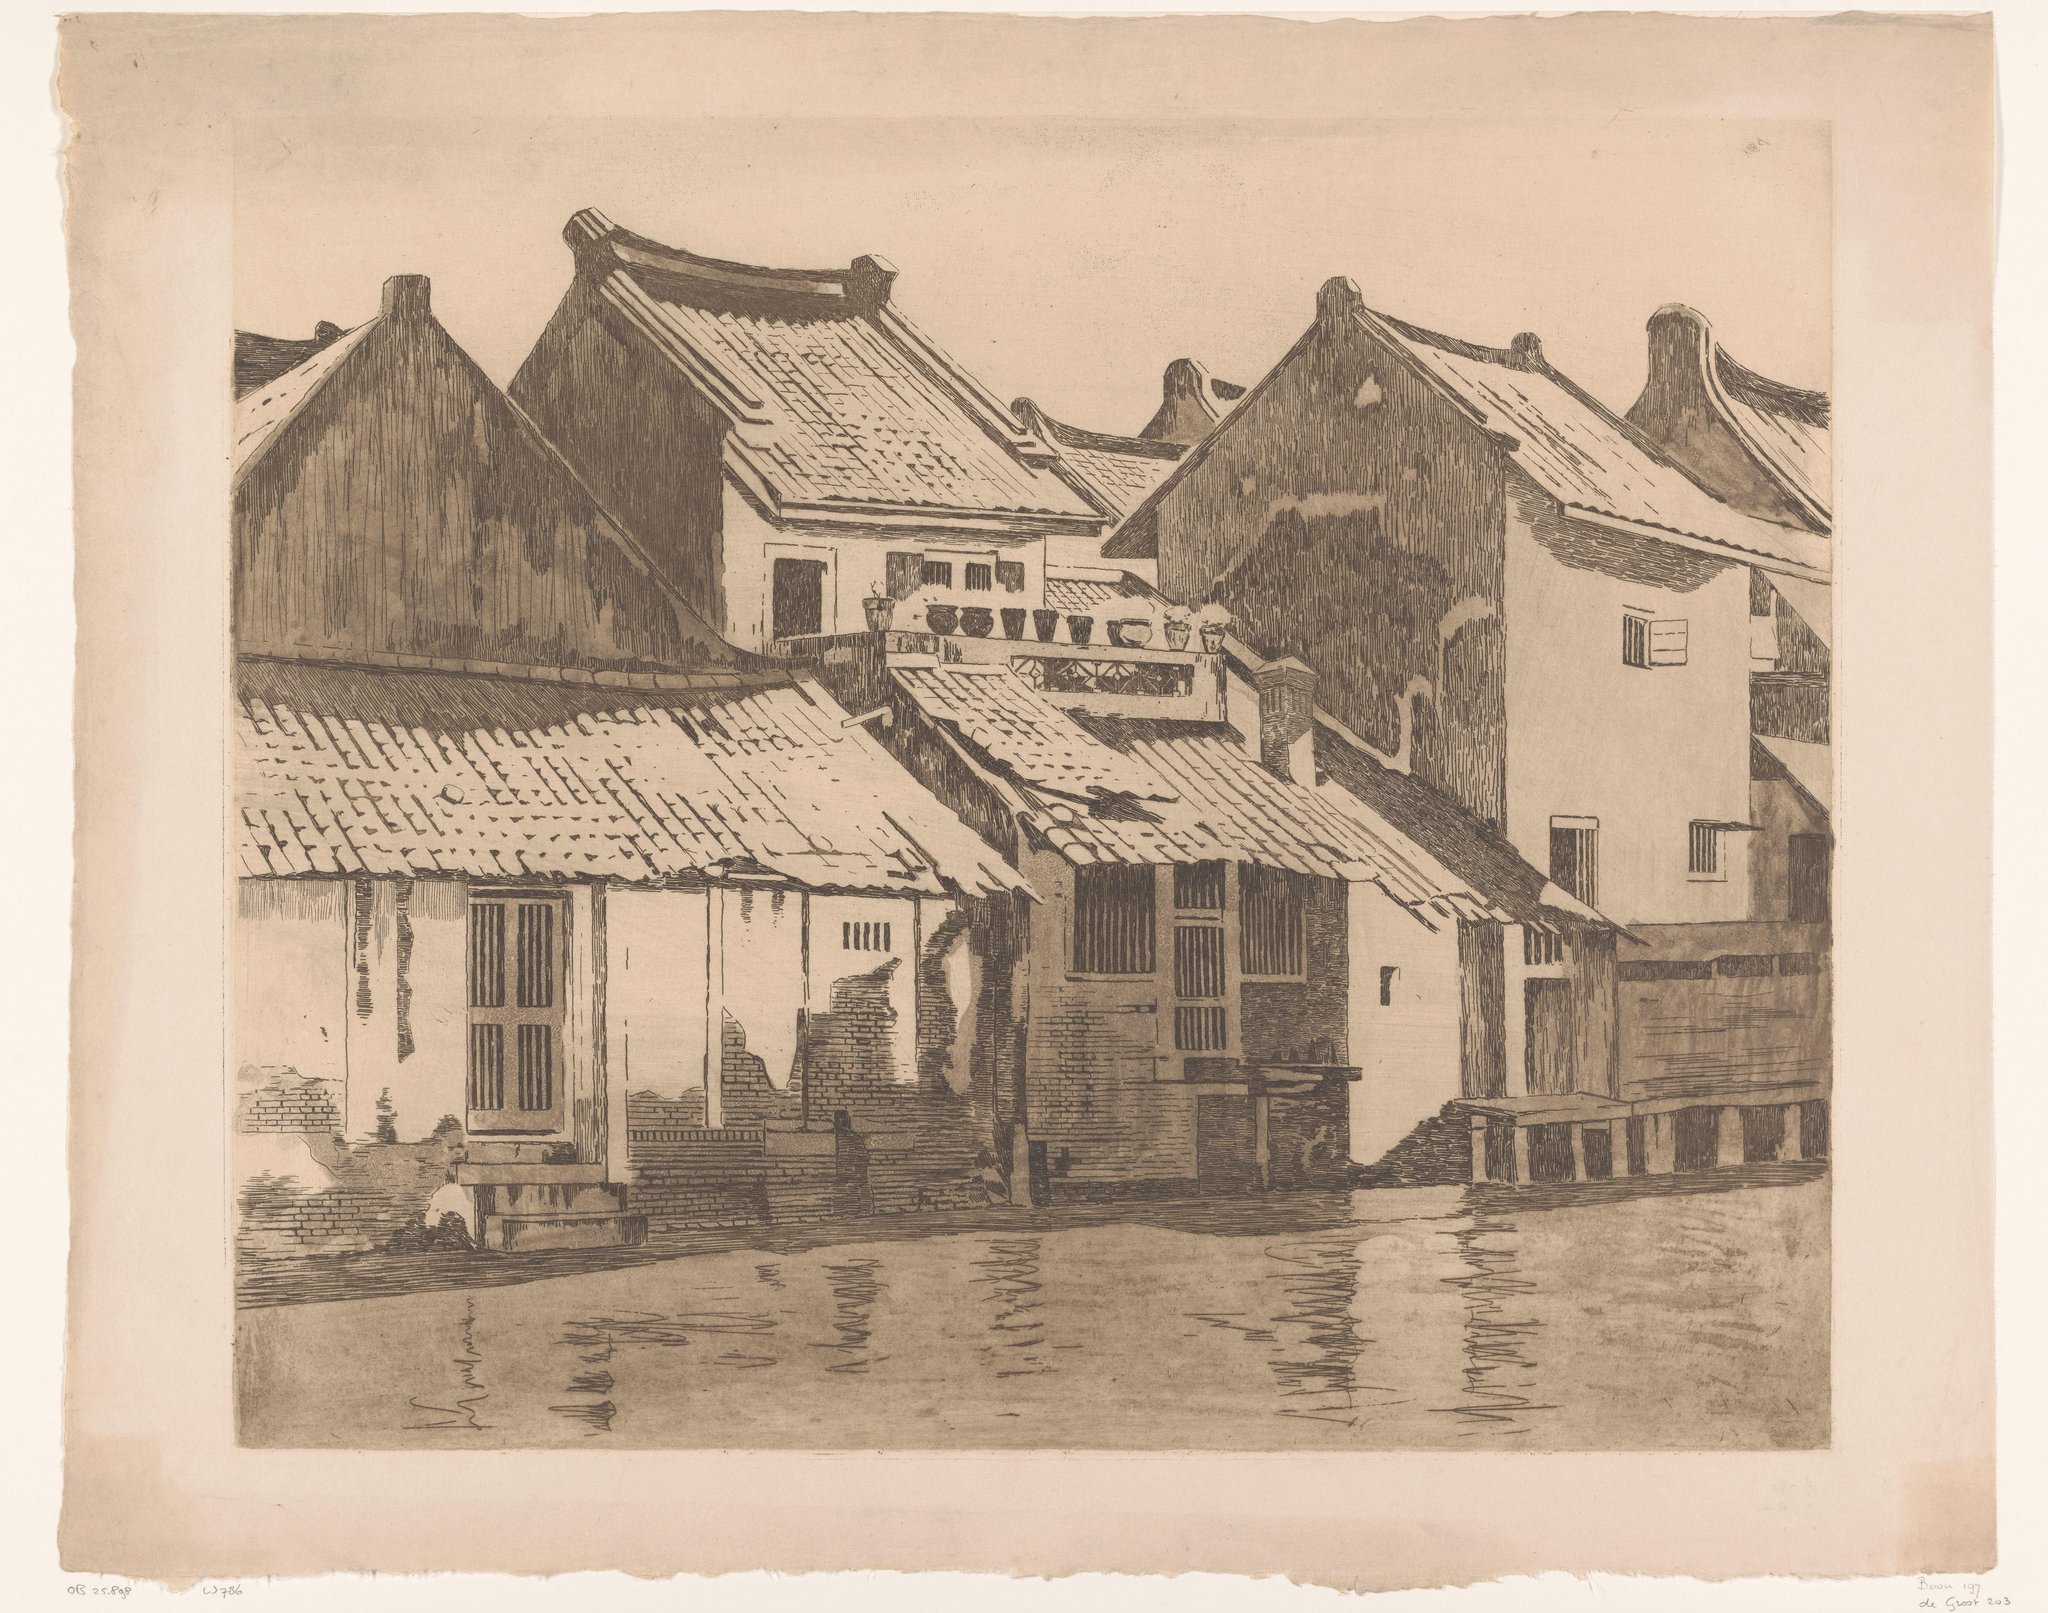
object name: print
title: Achtergevels van woningen aan een rivier in Batavia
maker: willem witsen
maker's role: draughtsman, painter, print maker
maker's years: 1860-1923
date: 1921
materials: paper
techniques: aquatint, etching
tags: urban housing, canals, waters (in city), batavia